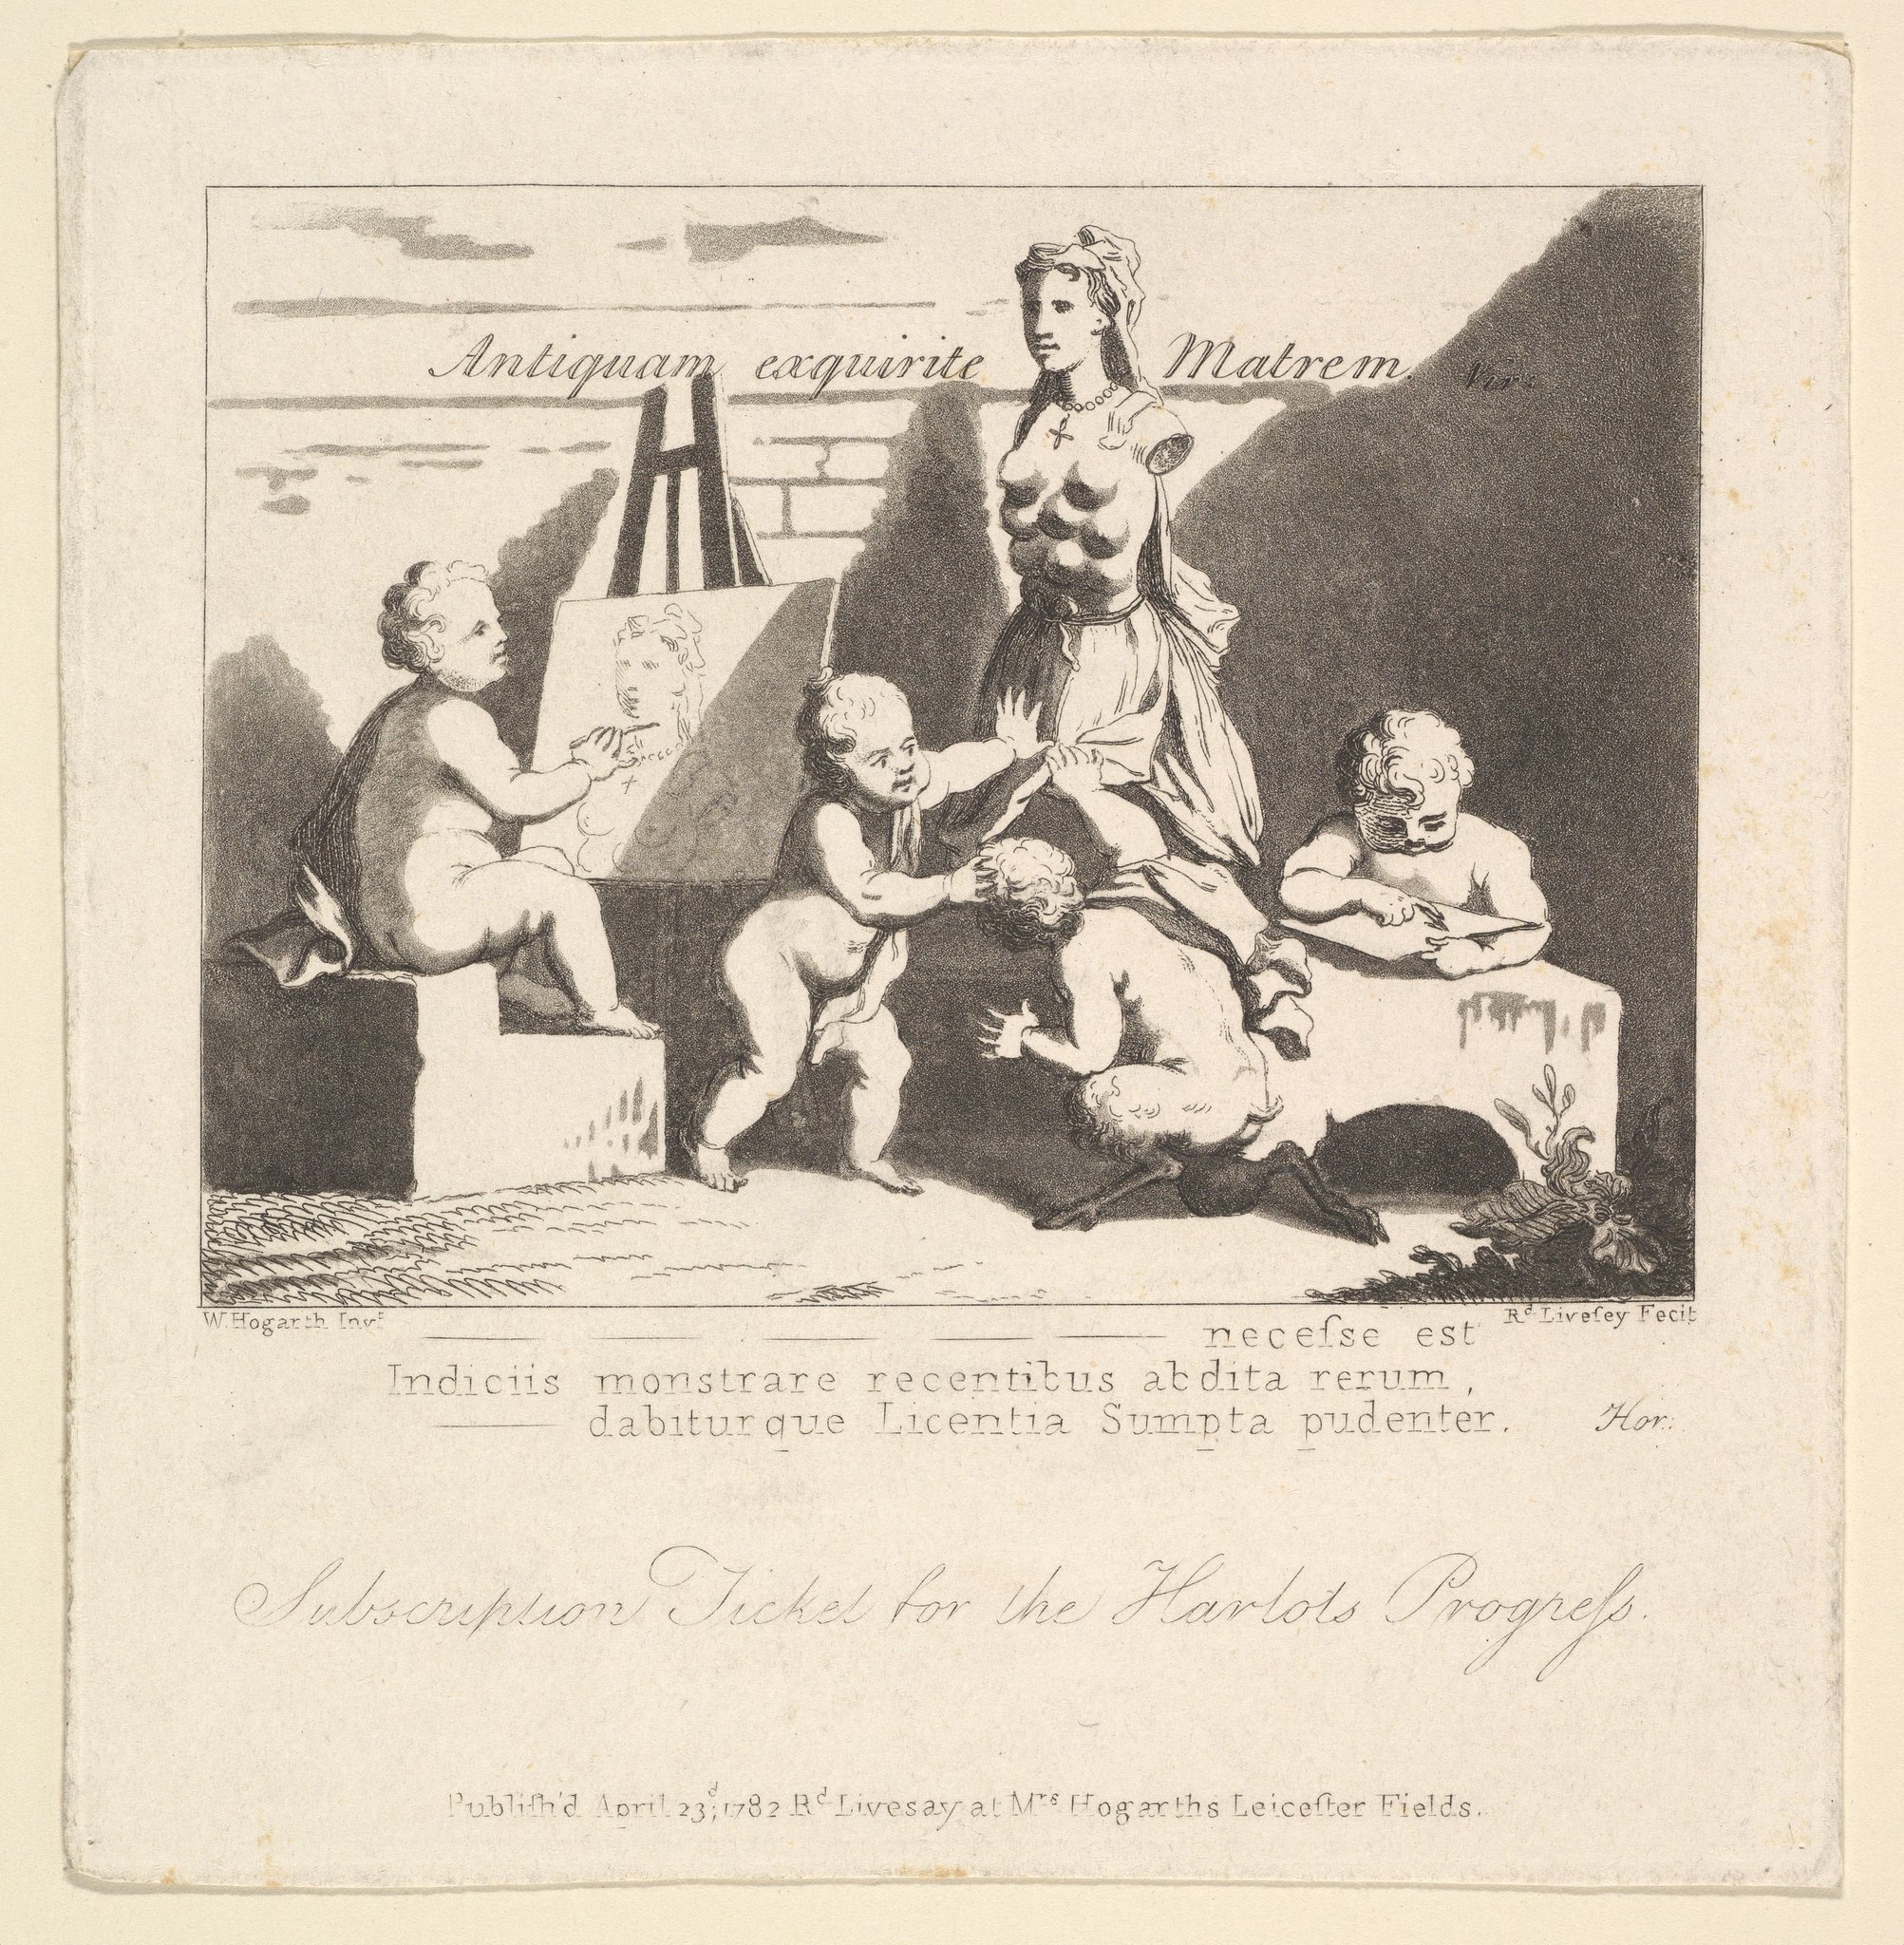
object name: print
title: Boys Peeping at Nature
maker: richard livesay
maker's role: artist and publisher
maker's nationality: british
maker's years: 1750-1826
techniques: aquatint, etching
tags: painting,sculpture,boys,playing,reading